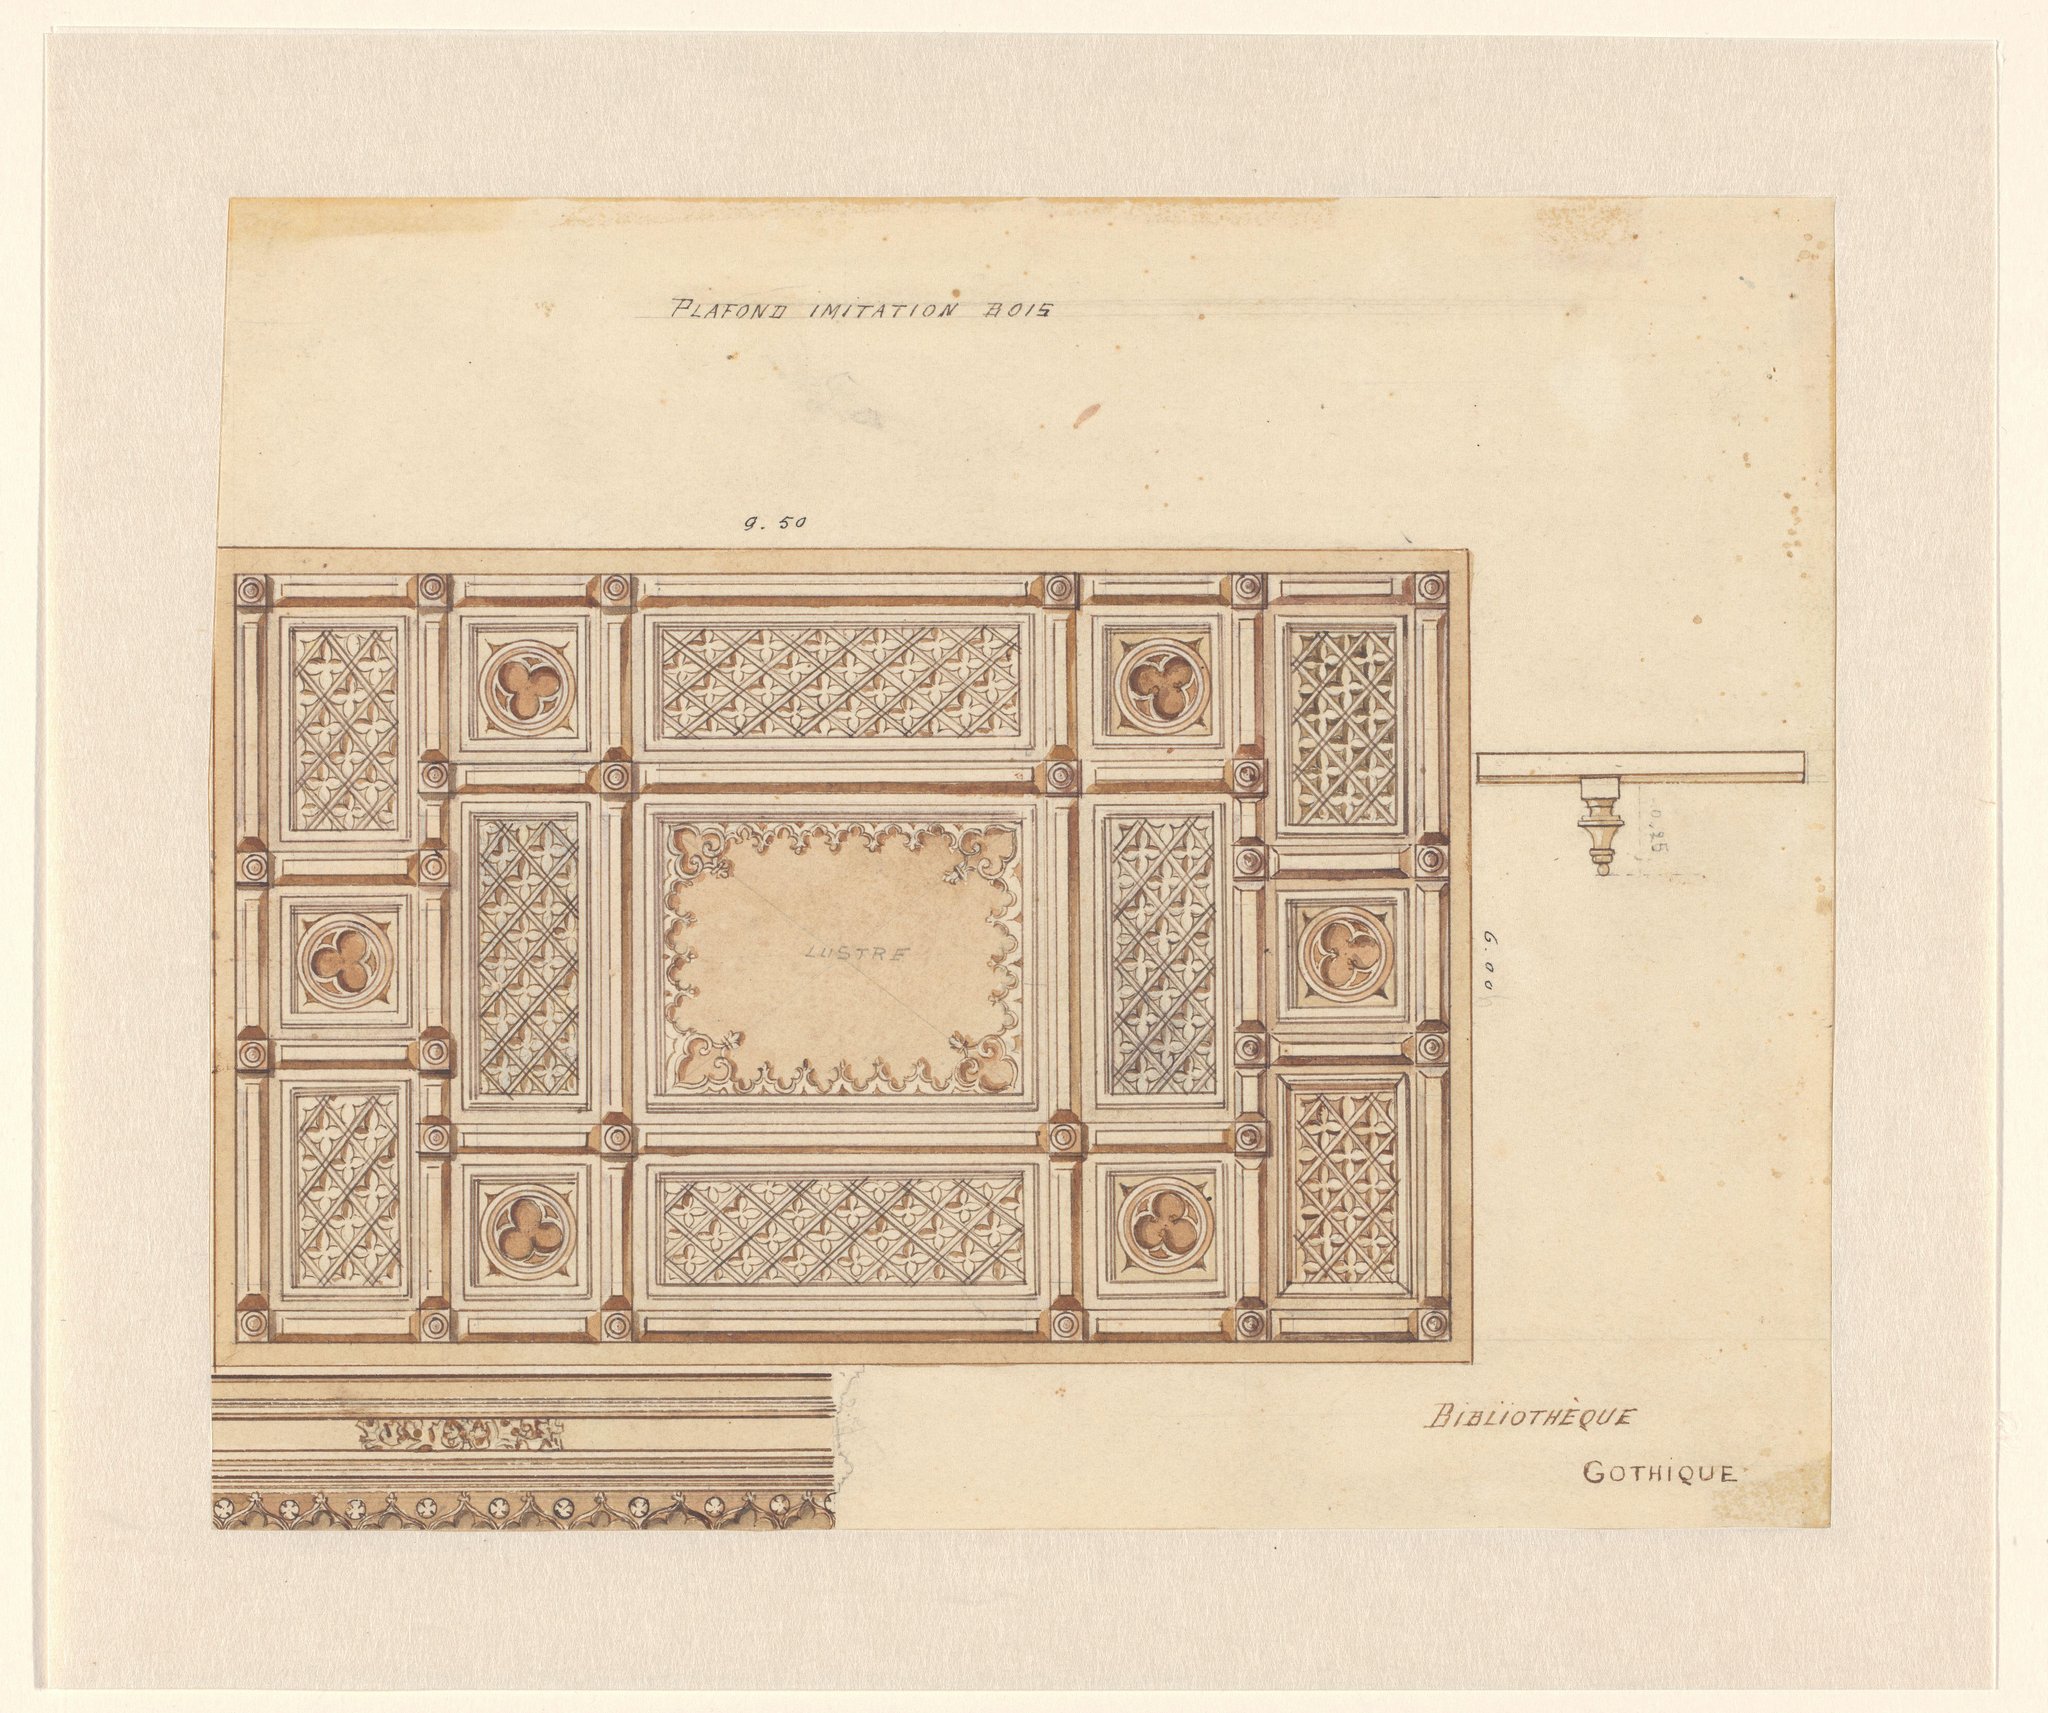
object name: print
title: Portret van Nicolas de la Fauconnière de Catinat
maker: Anonymous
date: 1717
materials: paper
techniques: engraving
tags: historical persons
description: Prent mogelijk uit: Theatrum Europaeum continuatum. Frankfurt am Main: erven Carl Gustav Merian, 1717, dl. 13.